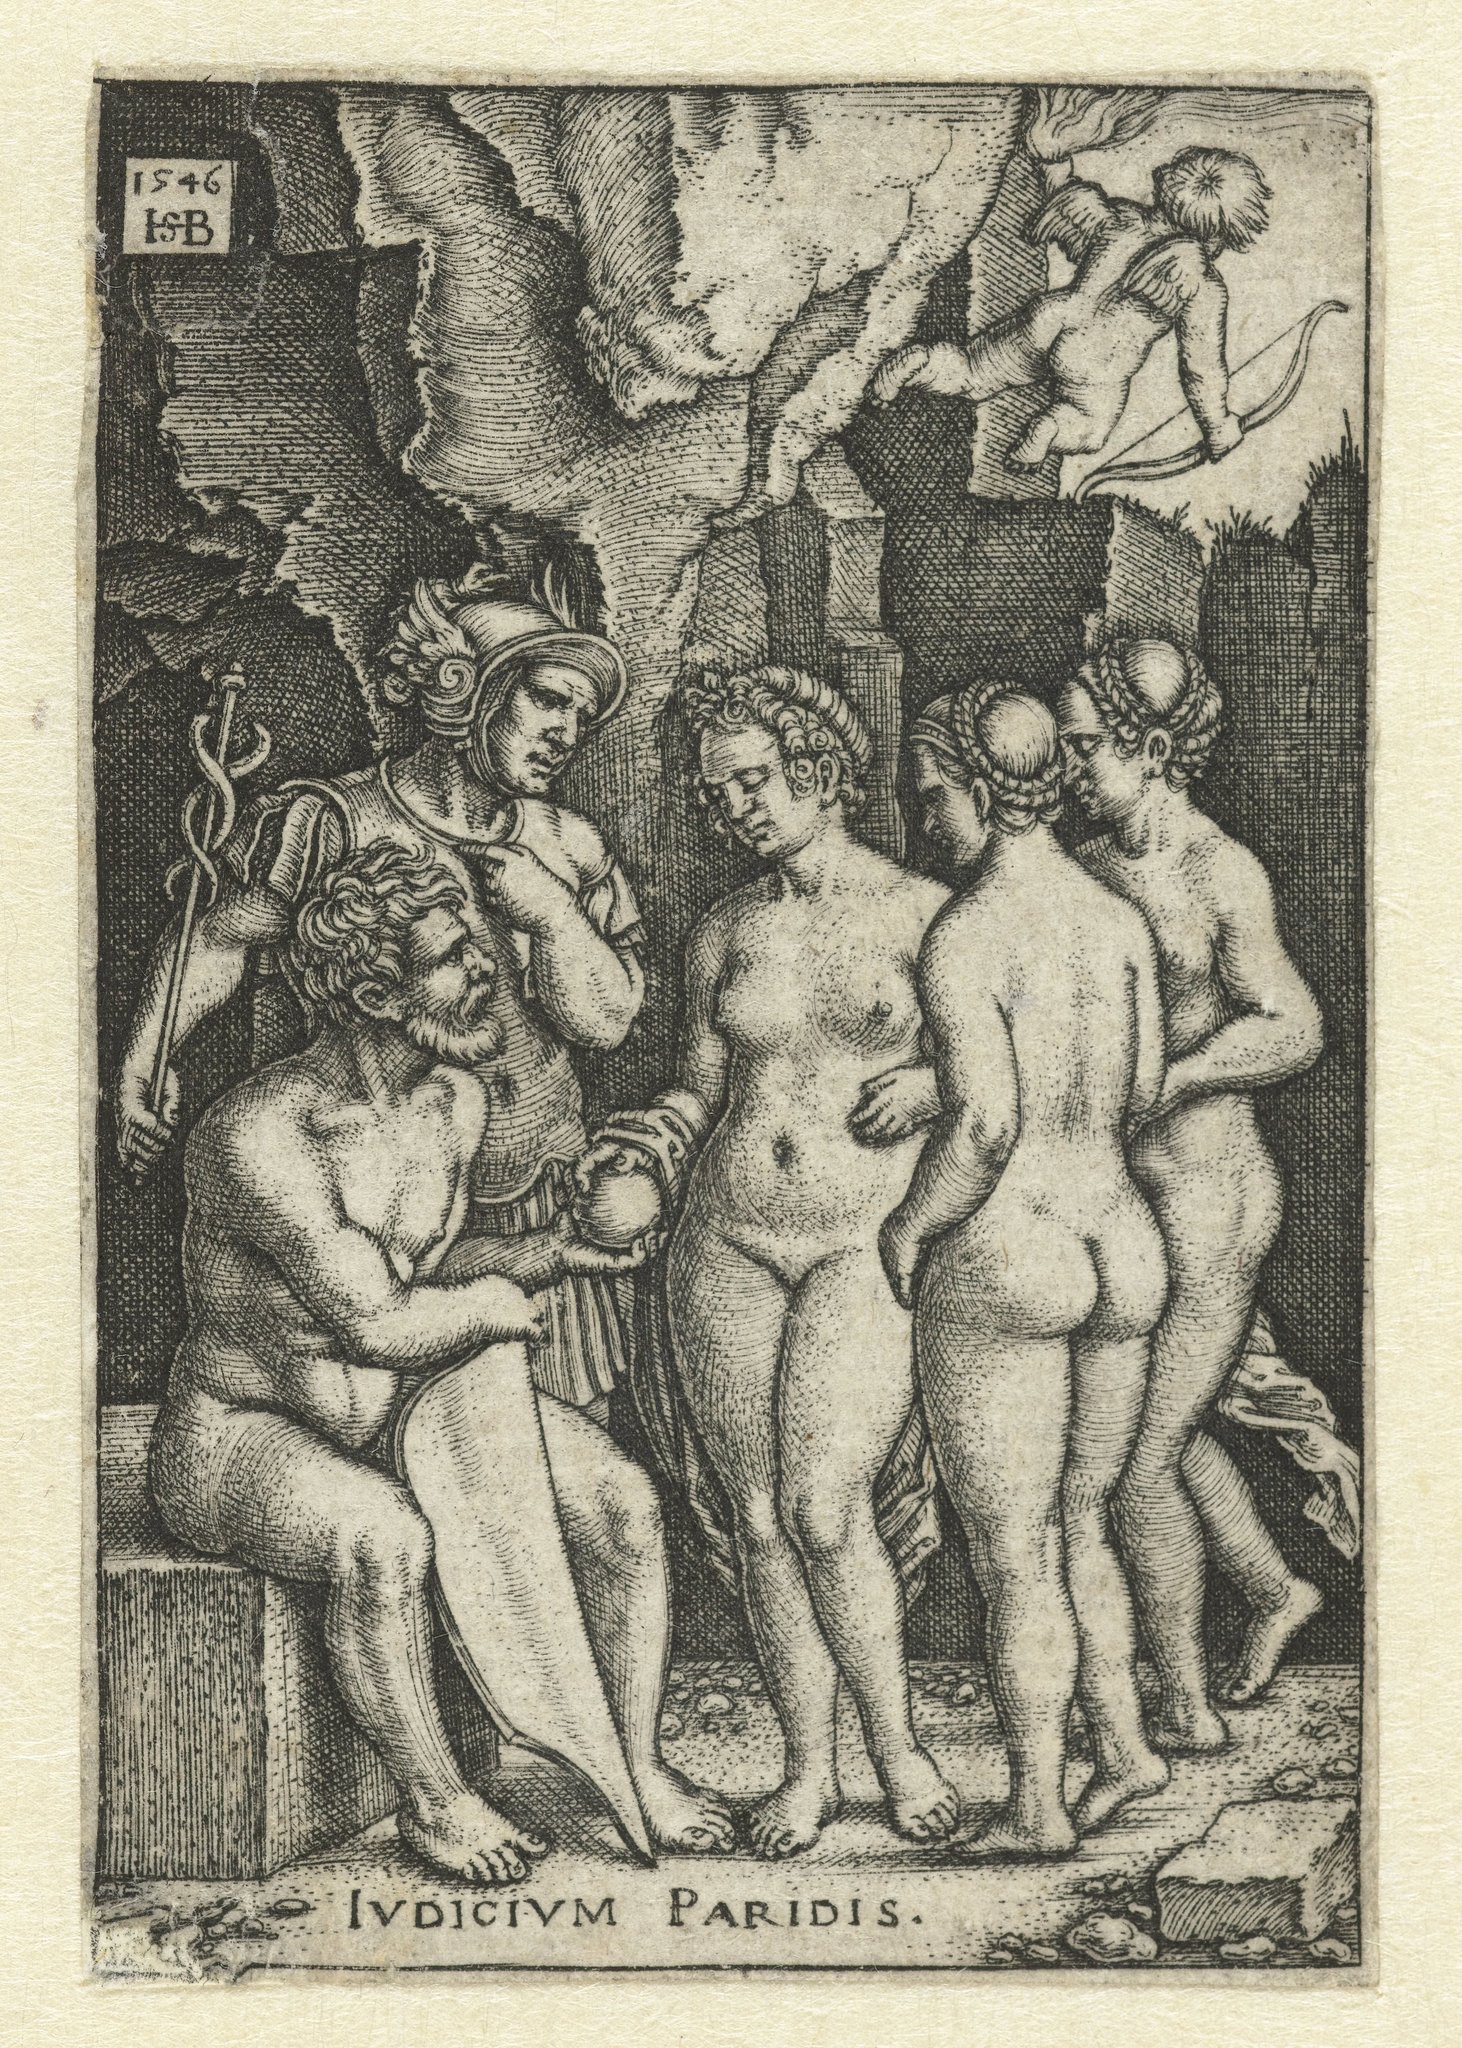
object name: print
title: Oordeel van Paris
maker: hans sebald beham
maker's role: designer, draughtsman, print maker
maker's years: 1500-1550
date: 1546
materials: paper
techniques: engraving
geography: frankfurt am main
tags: the judgement of paris (mercury present)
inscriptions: collector's mark: Lugt 2228a